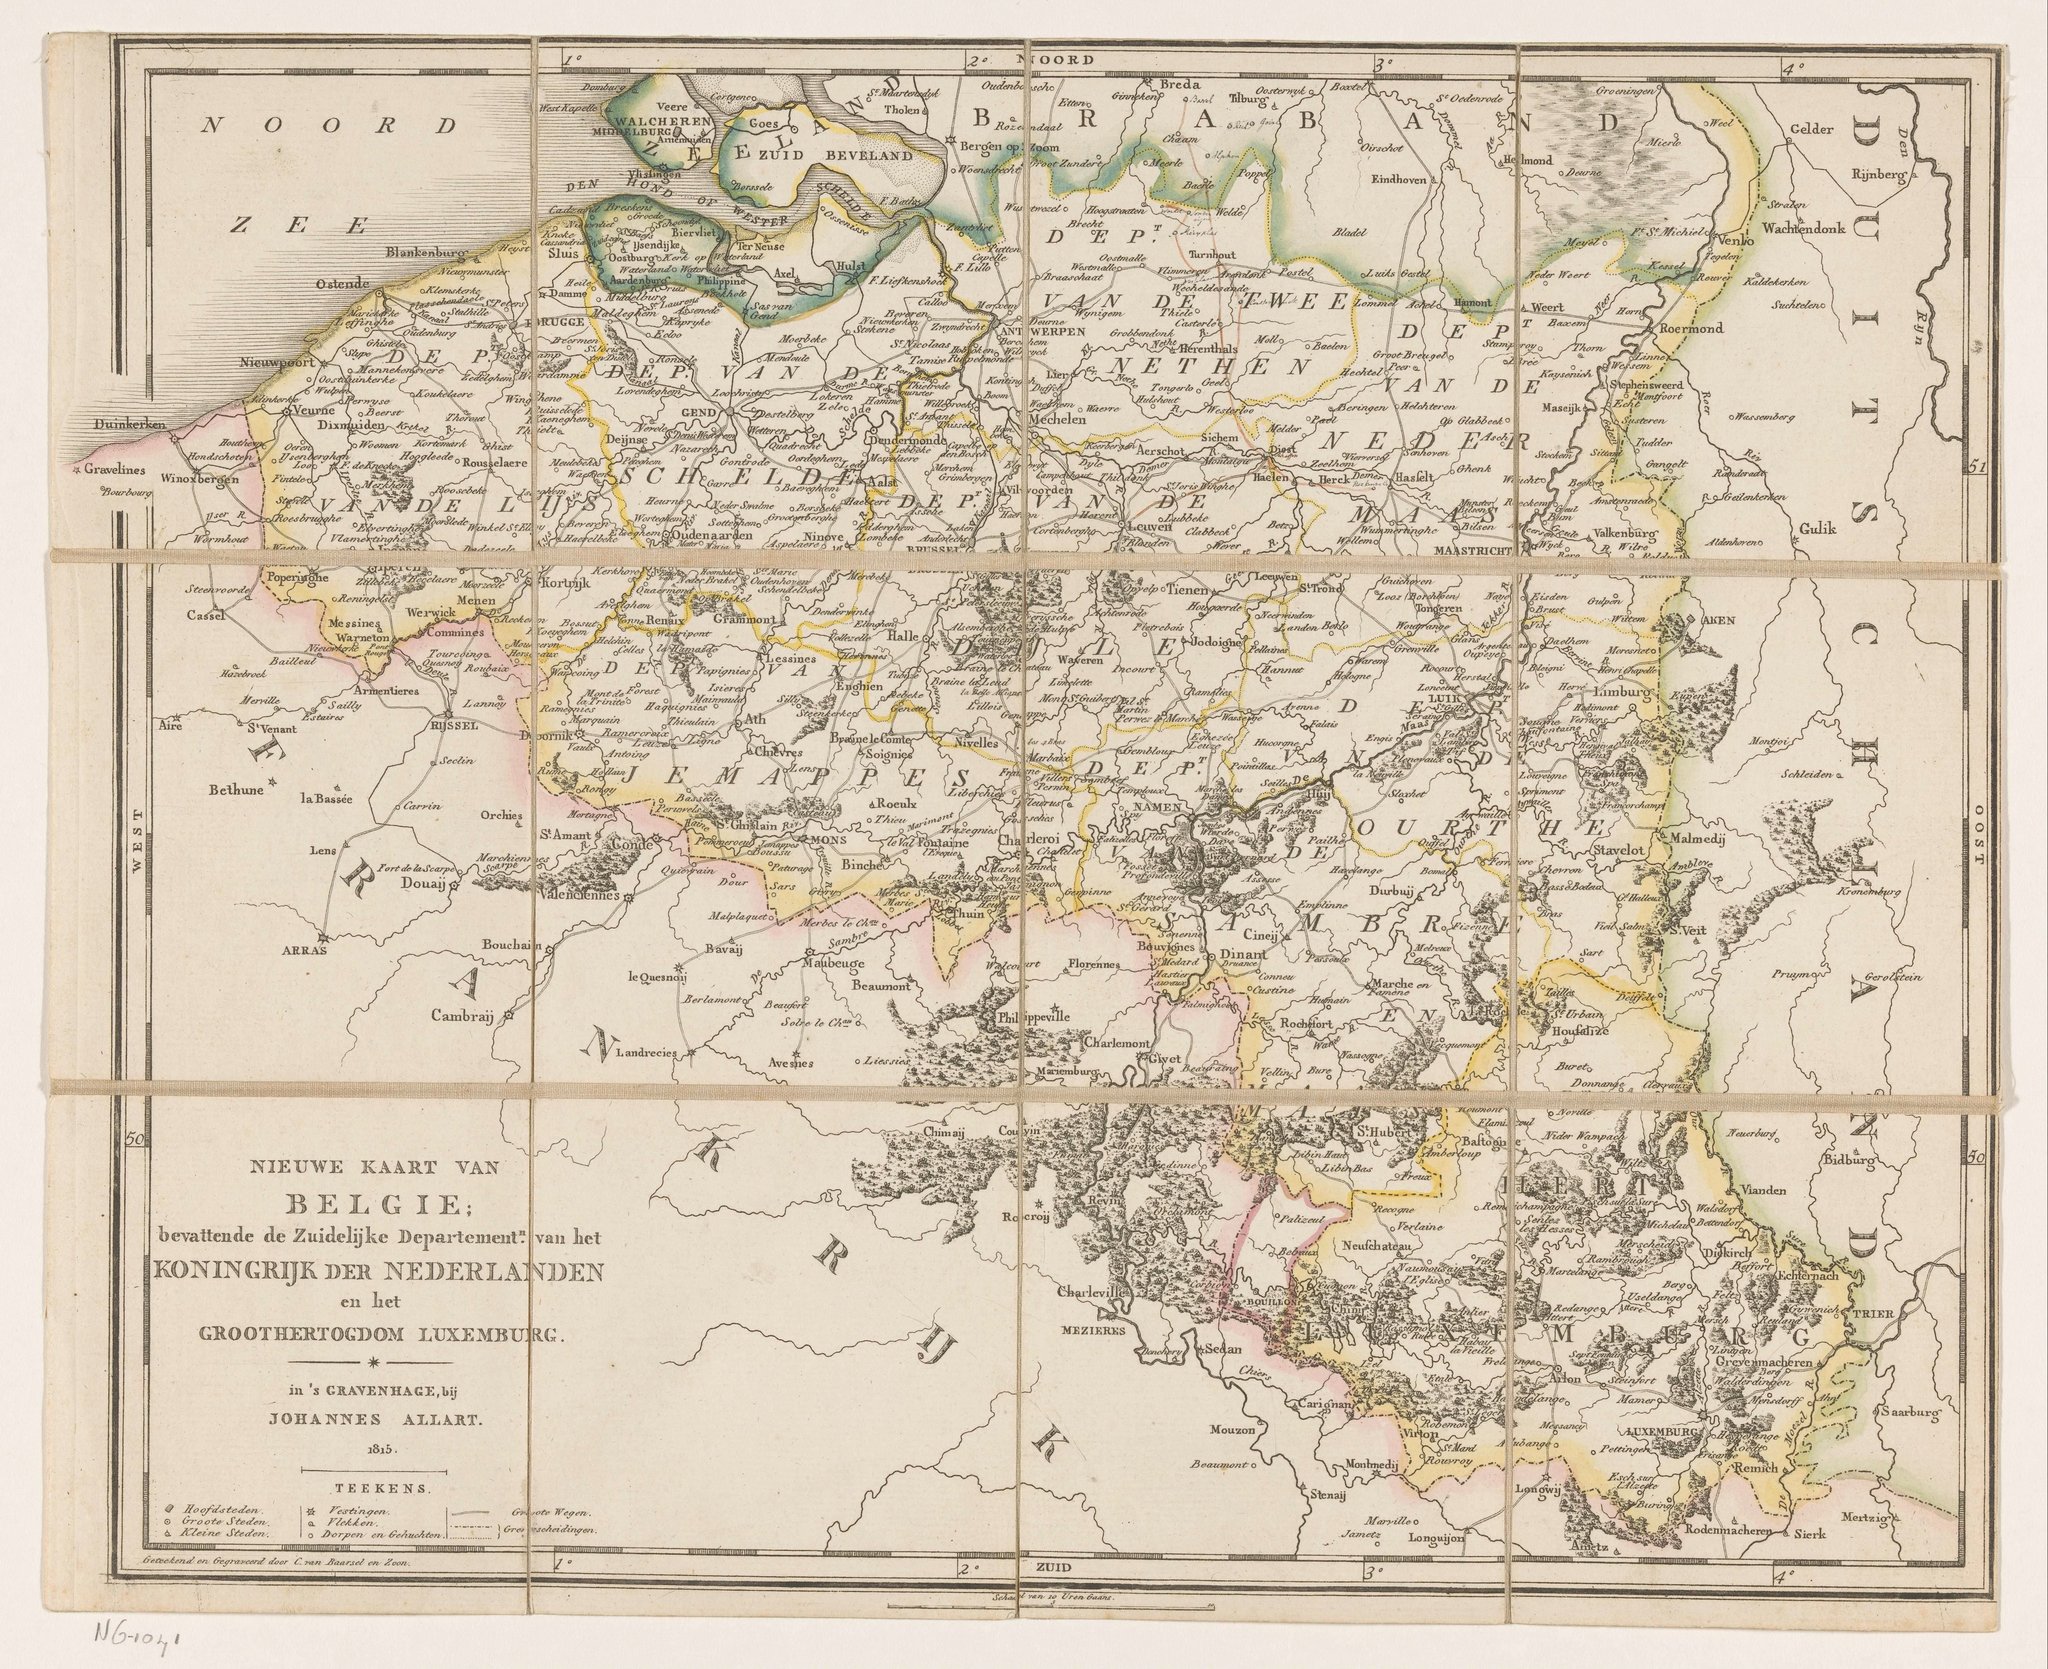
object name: map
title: Nieuwe kaart van België; bevattende de Zuidelijke Department.n van het Koningrijk der Nederlanden en het Groothertogdom Luxemburg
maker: johannes allart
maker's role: publisher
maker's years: 1754-1816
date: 1815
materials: linen, paper, watercolor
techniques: brush, engraving, etching, hand coloring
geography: the hague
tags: army 'en route', troop movements, transportation, maps of separate countries or regions, belgium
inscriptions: inscription: ‘1831. Tien-daagsche Veldtogt’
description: Kaart van België als onderdeel van het Koninkrijk der Nederlanden waarop met rood potlood is aangegeven de Tiendaagse Veldtocht van augustus 1831. De kaart bestaat uit 9 losse blaadjes, op linnen geplakt.